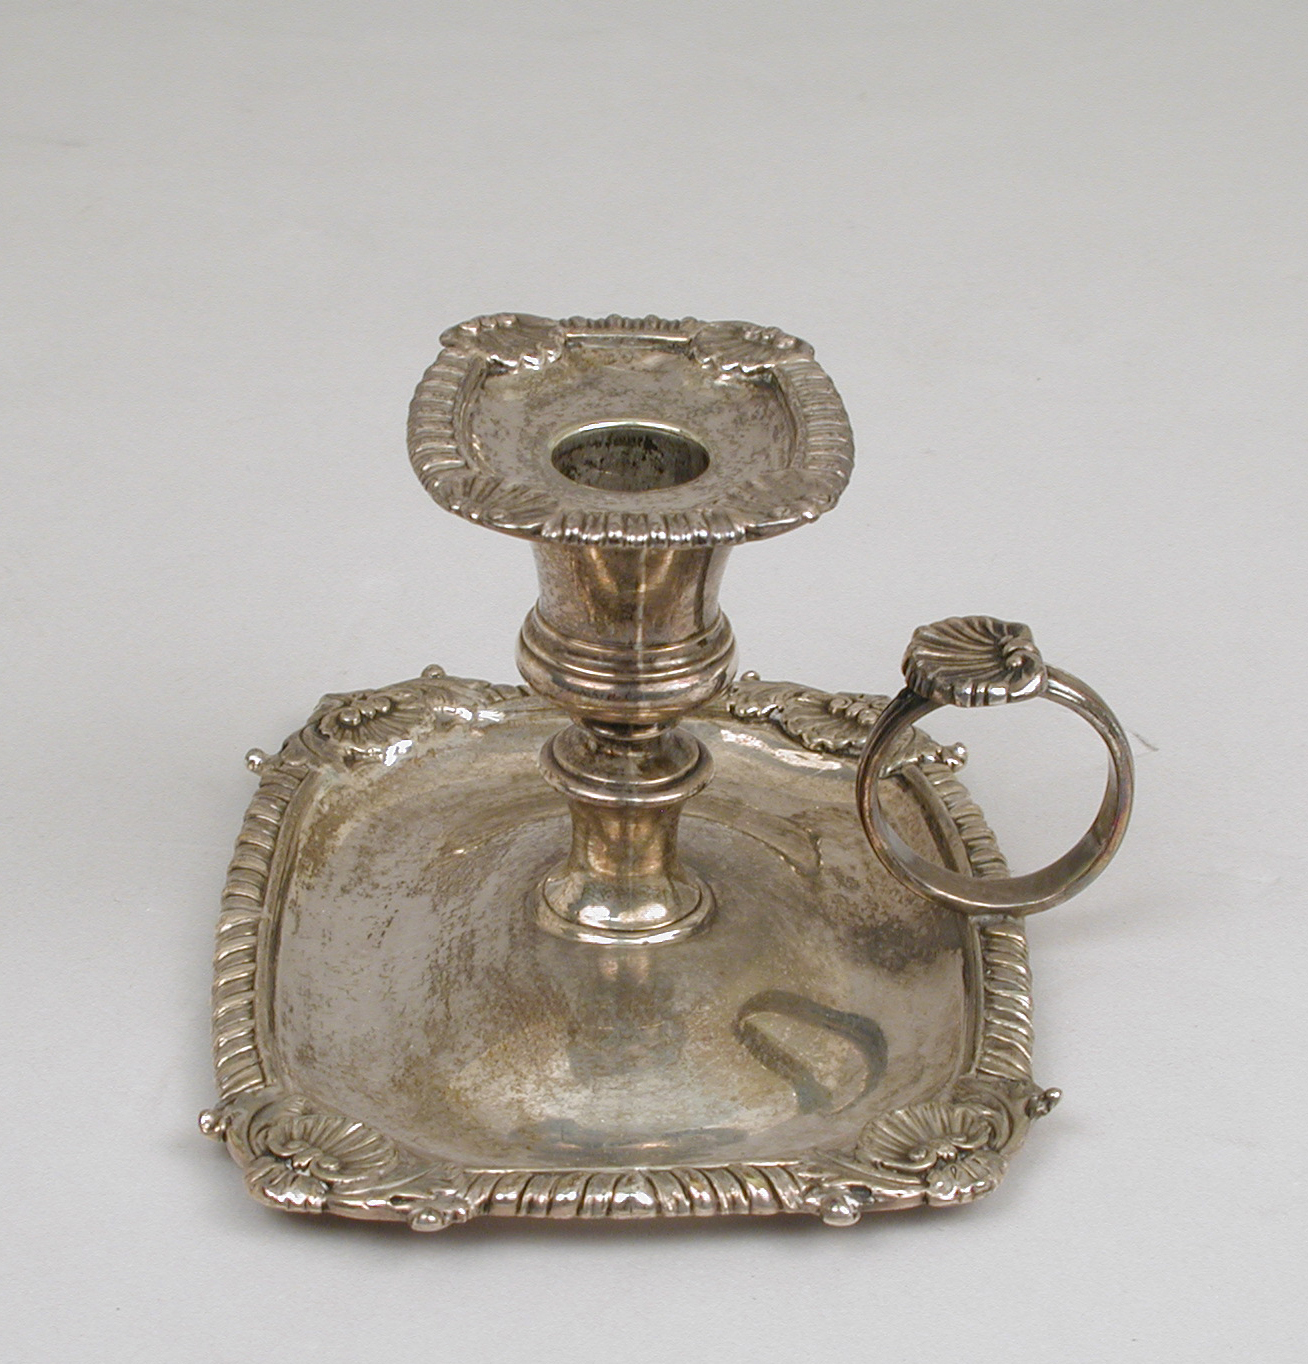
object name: chamber candlestick or taperstick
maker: rebecca emes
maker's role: maker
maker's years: 1808-1825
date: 1809-1810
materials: silver